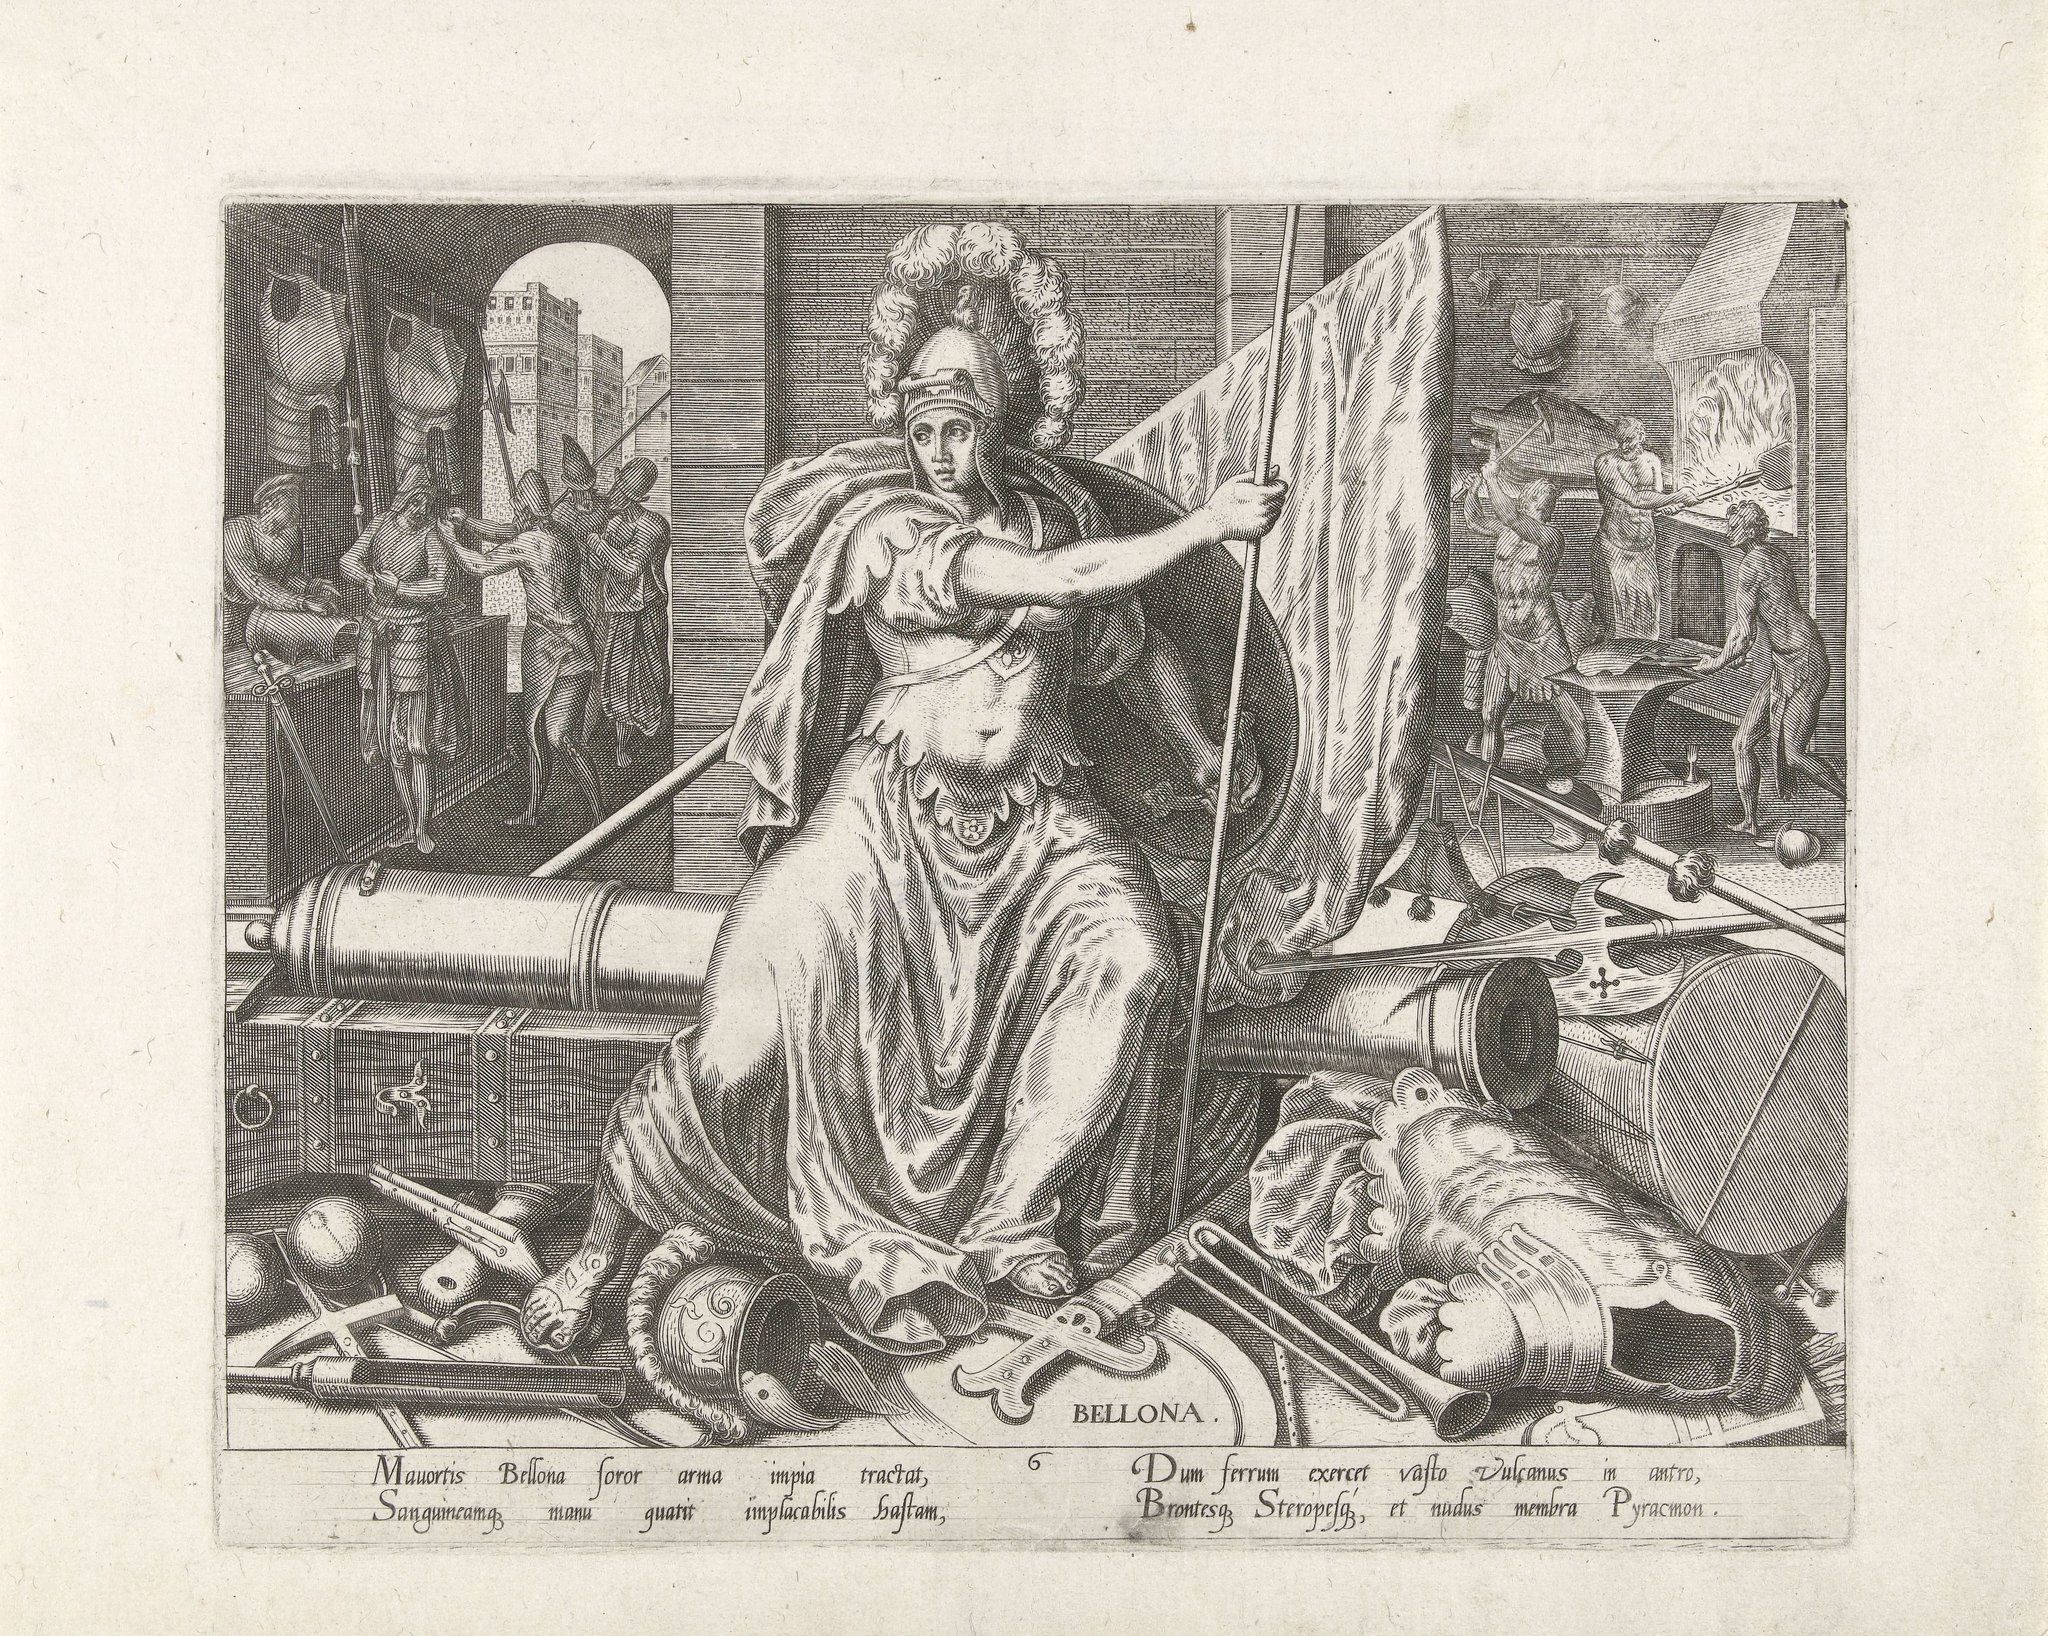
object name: print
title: Menselijke bedrijvigheden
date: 1574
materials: paper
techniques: engraving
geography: antwerp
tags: weapons, smith, blacksmith, bellona (enyo), 'artes mechanicae' (lanificium, armatura, navigatio, agricultura, venatio, medicina, theatrica)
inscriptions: collector's mark: Lugt 2228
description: De Romeinse godin Bellona als personificatie van de wapenindustrie. Zij zit, te midden van op de grond liggende harnassen en wapens op een kanon. Op de achtergrond rechts een smidse waar wapenrustingen worden gemaakt. Links een winkel waar harnassen worden verkocht. De prent heeft een Latijns onderschrift en maakt deel uit van een prentenreeks over de menselijke bedrijvigheden.